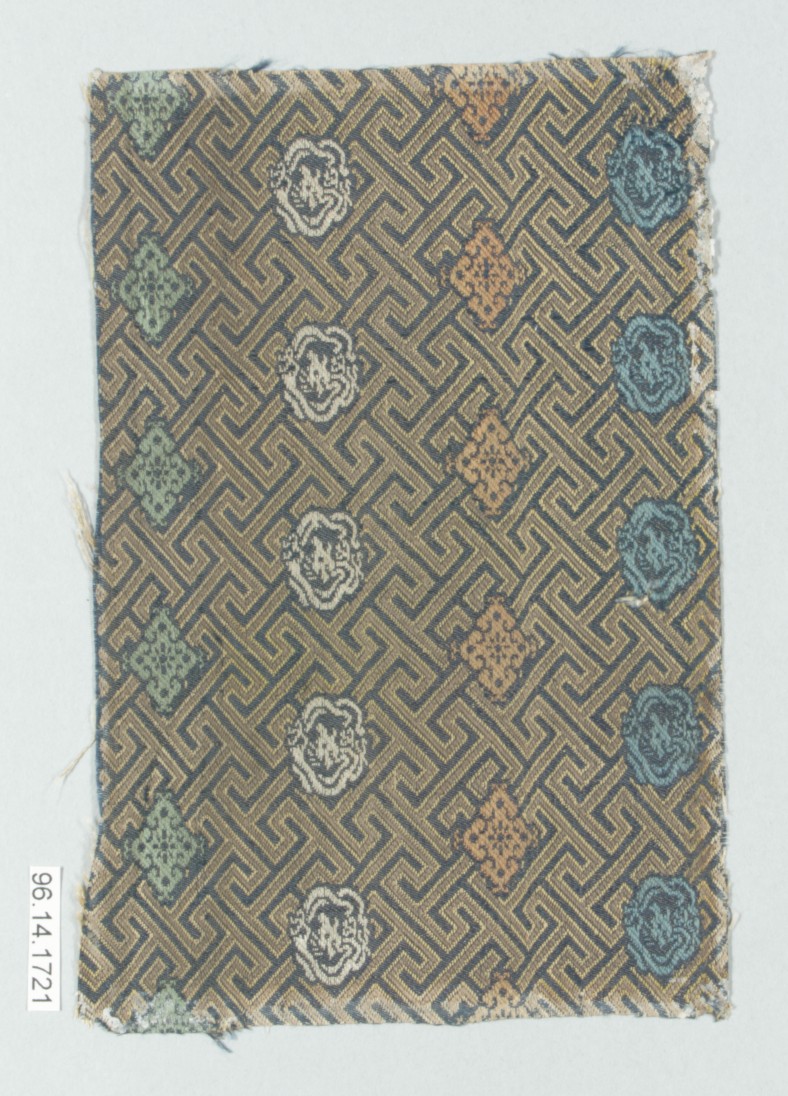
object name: piece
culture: japanese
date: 1701-1900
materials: silk